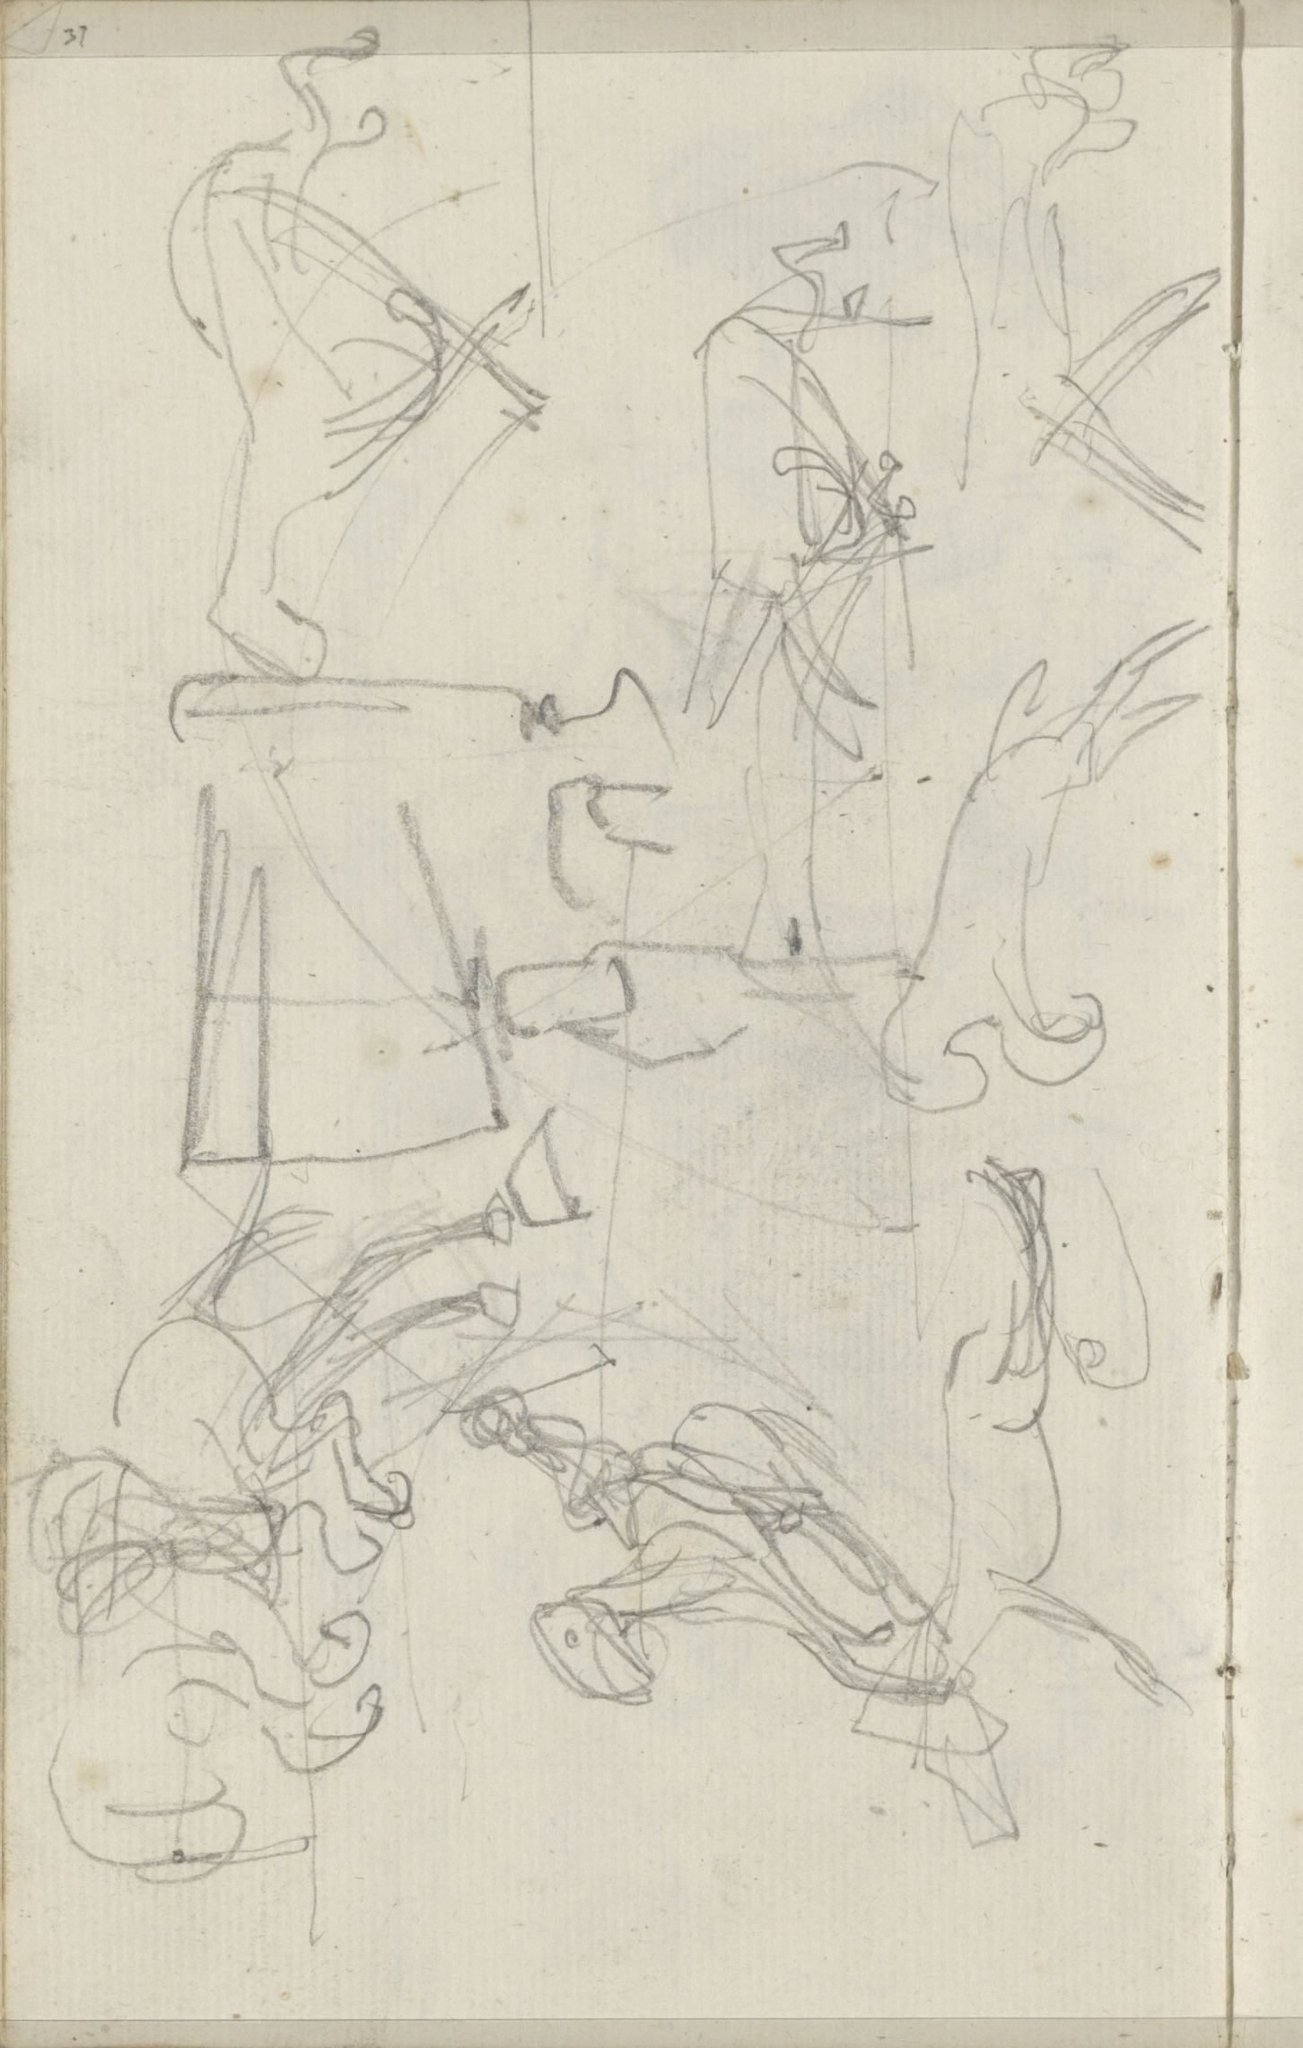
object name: sketchbook leaf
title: Bewegingsstudies van een paard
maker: george hendrik breitner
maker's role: draughtsman, painter, print maker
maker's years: 1857-1923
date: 1880-1882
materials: paper, pencil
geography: scheveningen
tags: riding a horse, ass, or mule; rider, horseman, horse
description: Op één van de paarden zit een ruiter. Pagina 37 uit een schetsboek met 31 bladen.